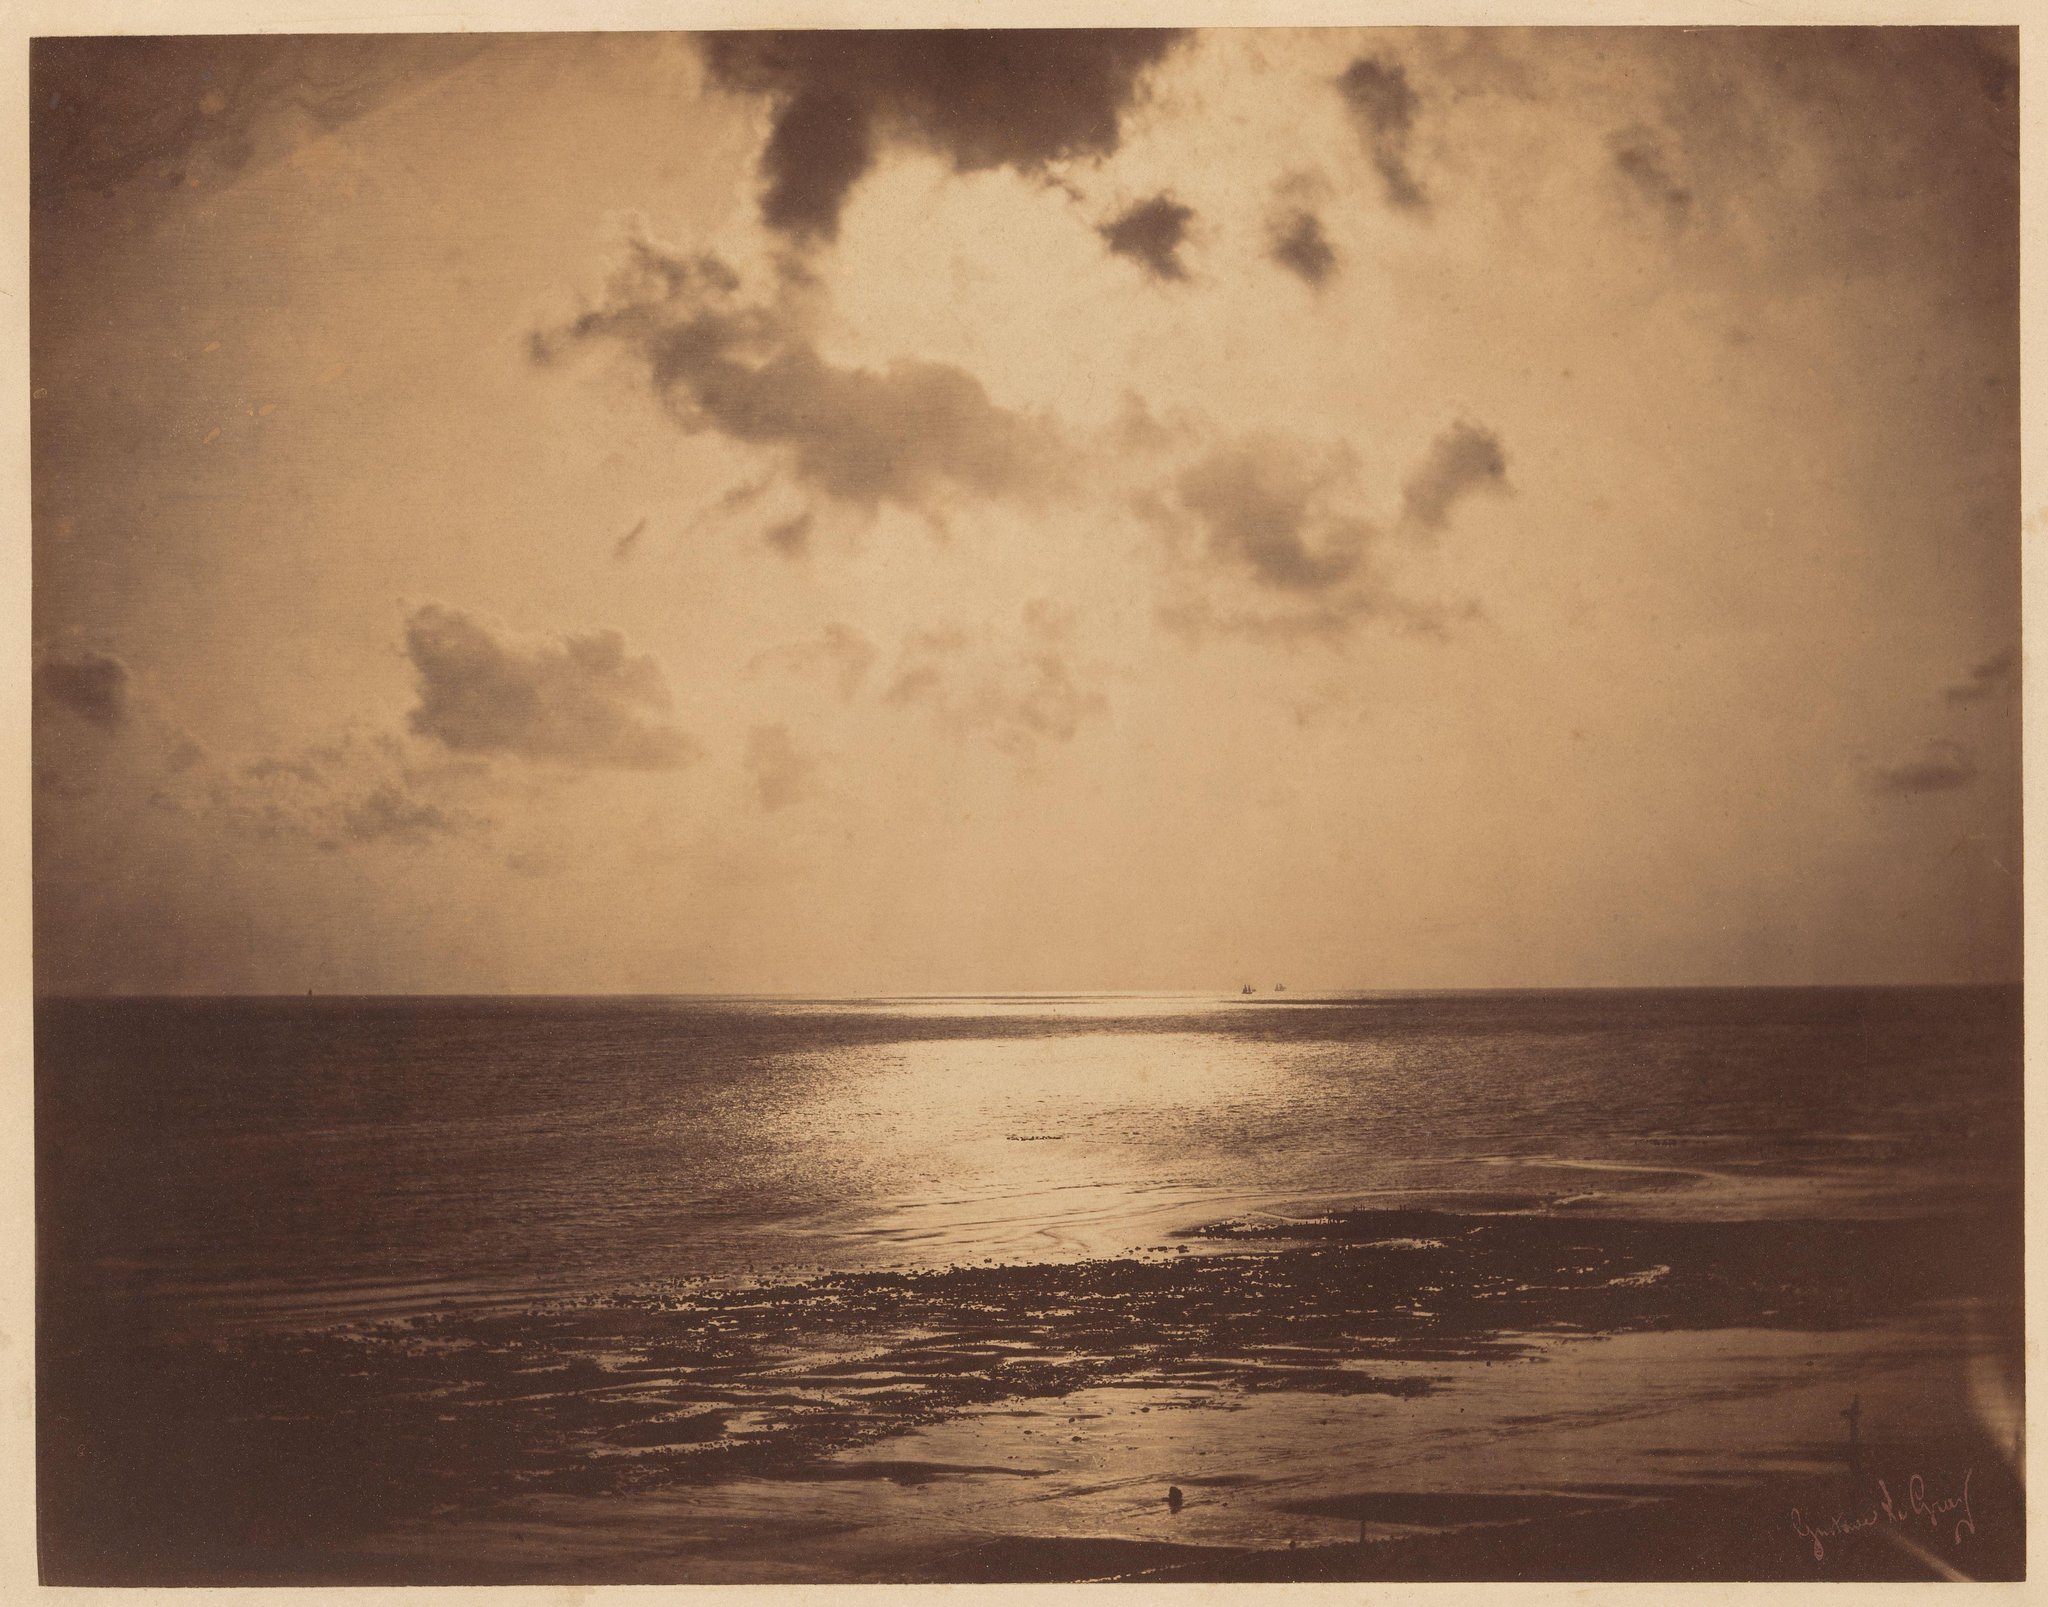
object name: photograph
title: Effet de Soleil - Océan - no. 23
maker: gustave le gray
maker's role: fotograaf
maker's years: 1820-1884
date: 1856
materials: cardboard, photographic support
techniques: albumen print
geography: france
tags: united states of america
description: Zeegezicht uit de fotocollectie 'Seascapes'.